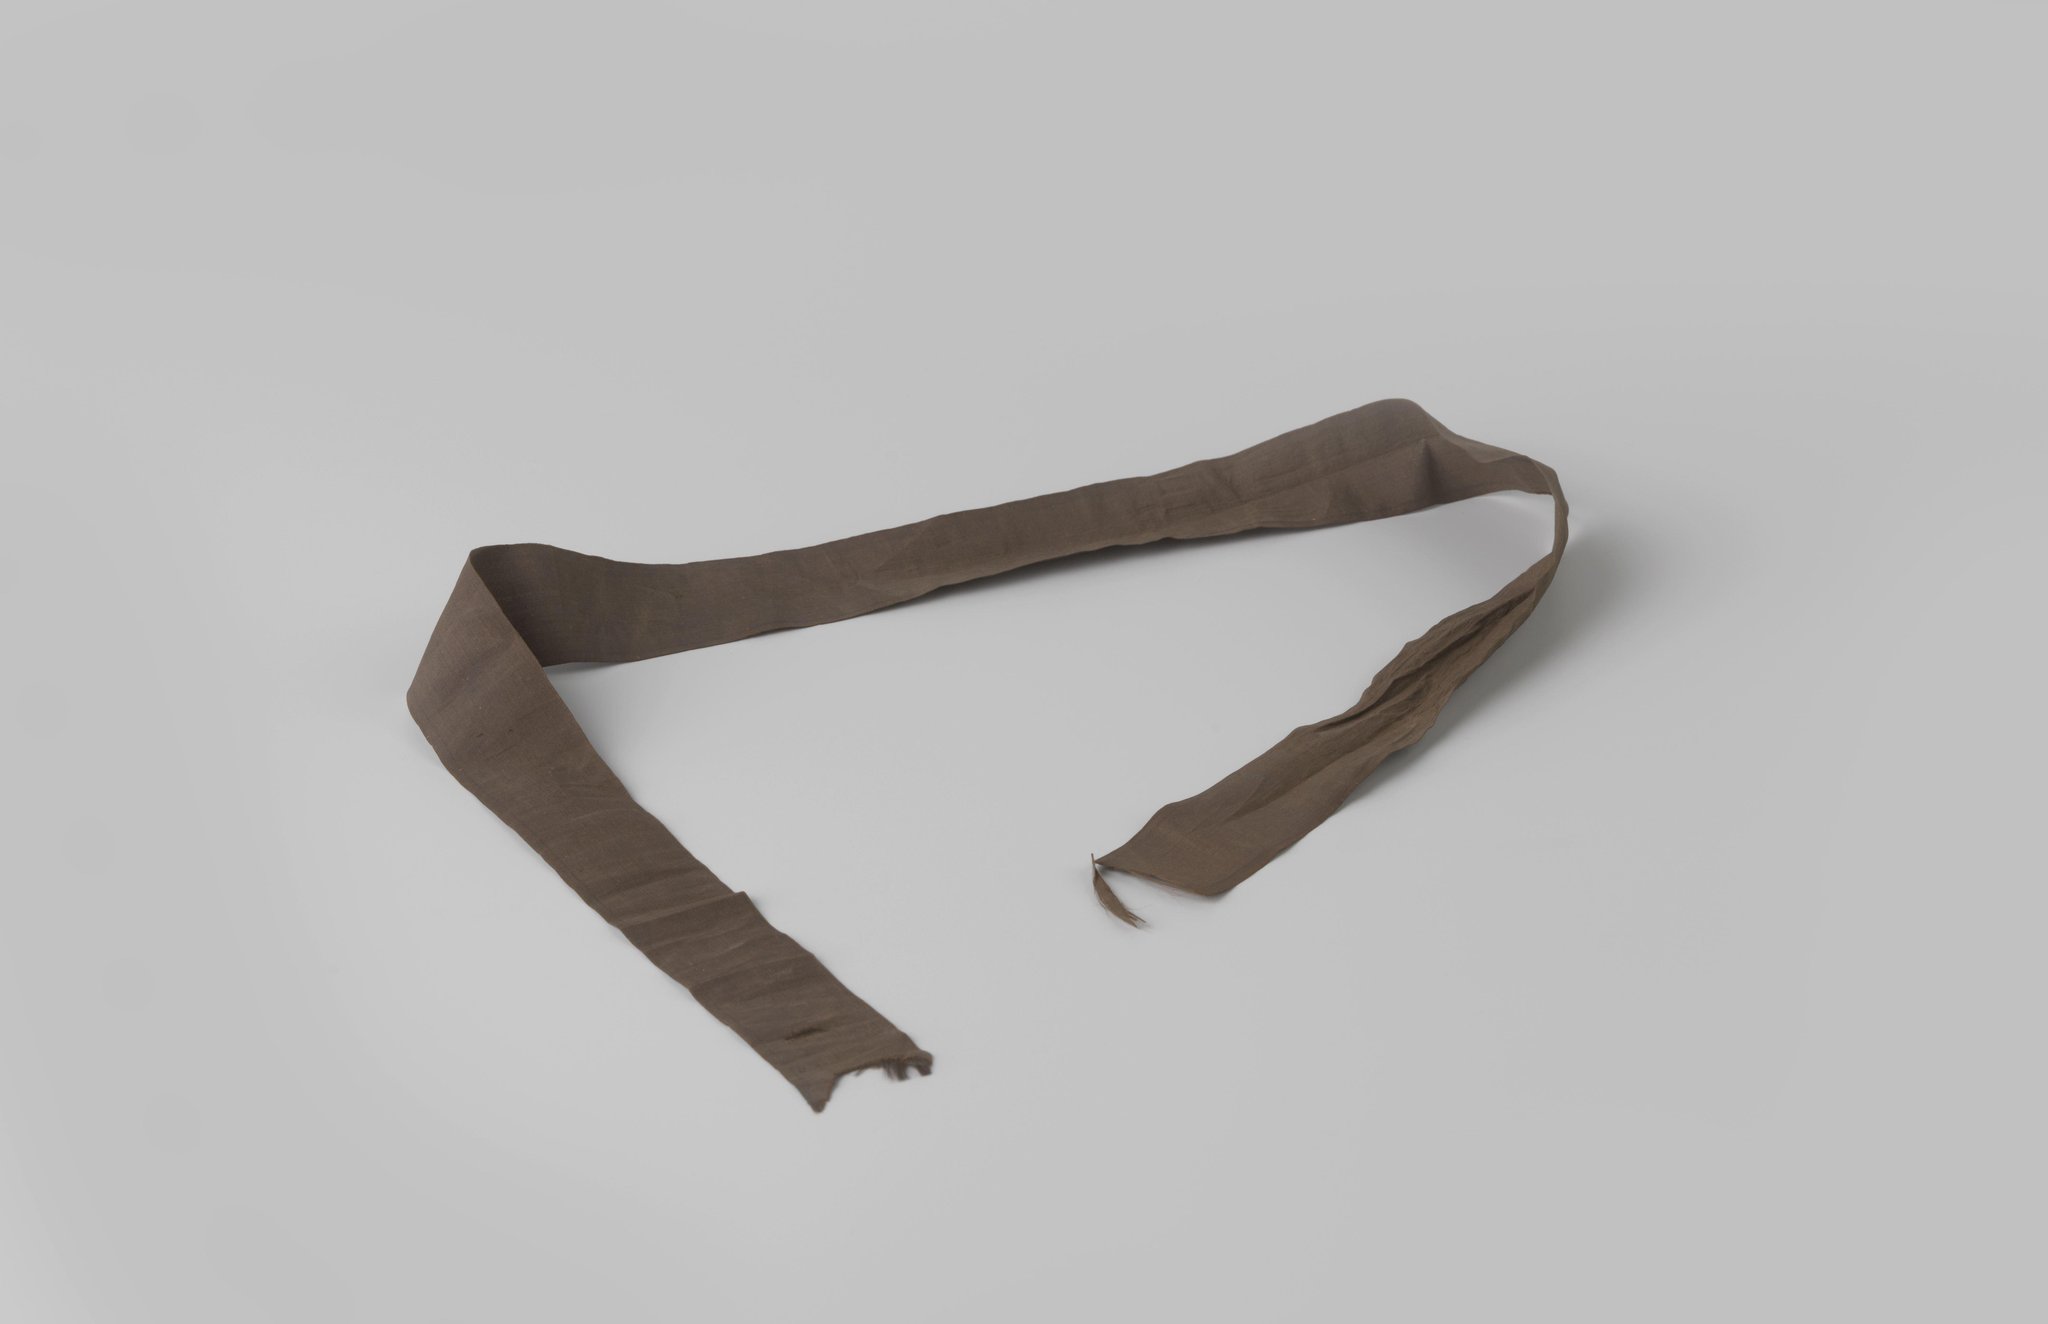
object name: hatband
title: Band behorend bij matrozenhoed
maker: Anonymous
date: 1800-1850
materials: gold thread, silk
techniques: weave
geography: netherlands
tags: netherlands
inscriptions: : ‘Kon: Ned: Marine’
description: Stuk zwart zijden lint (verschoten). Behorend bij matrozenhoed van het marinekorps.